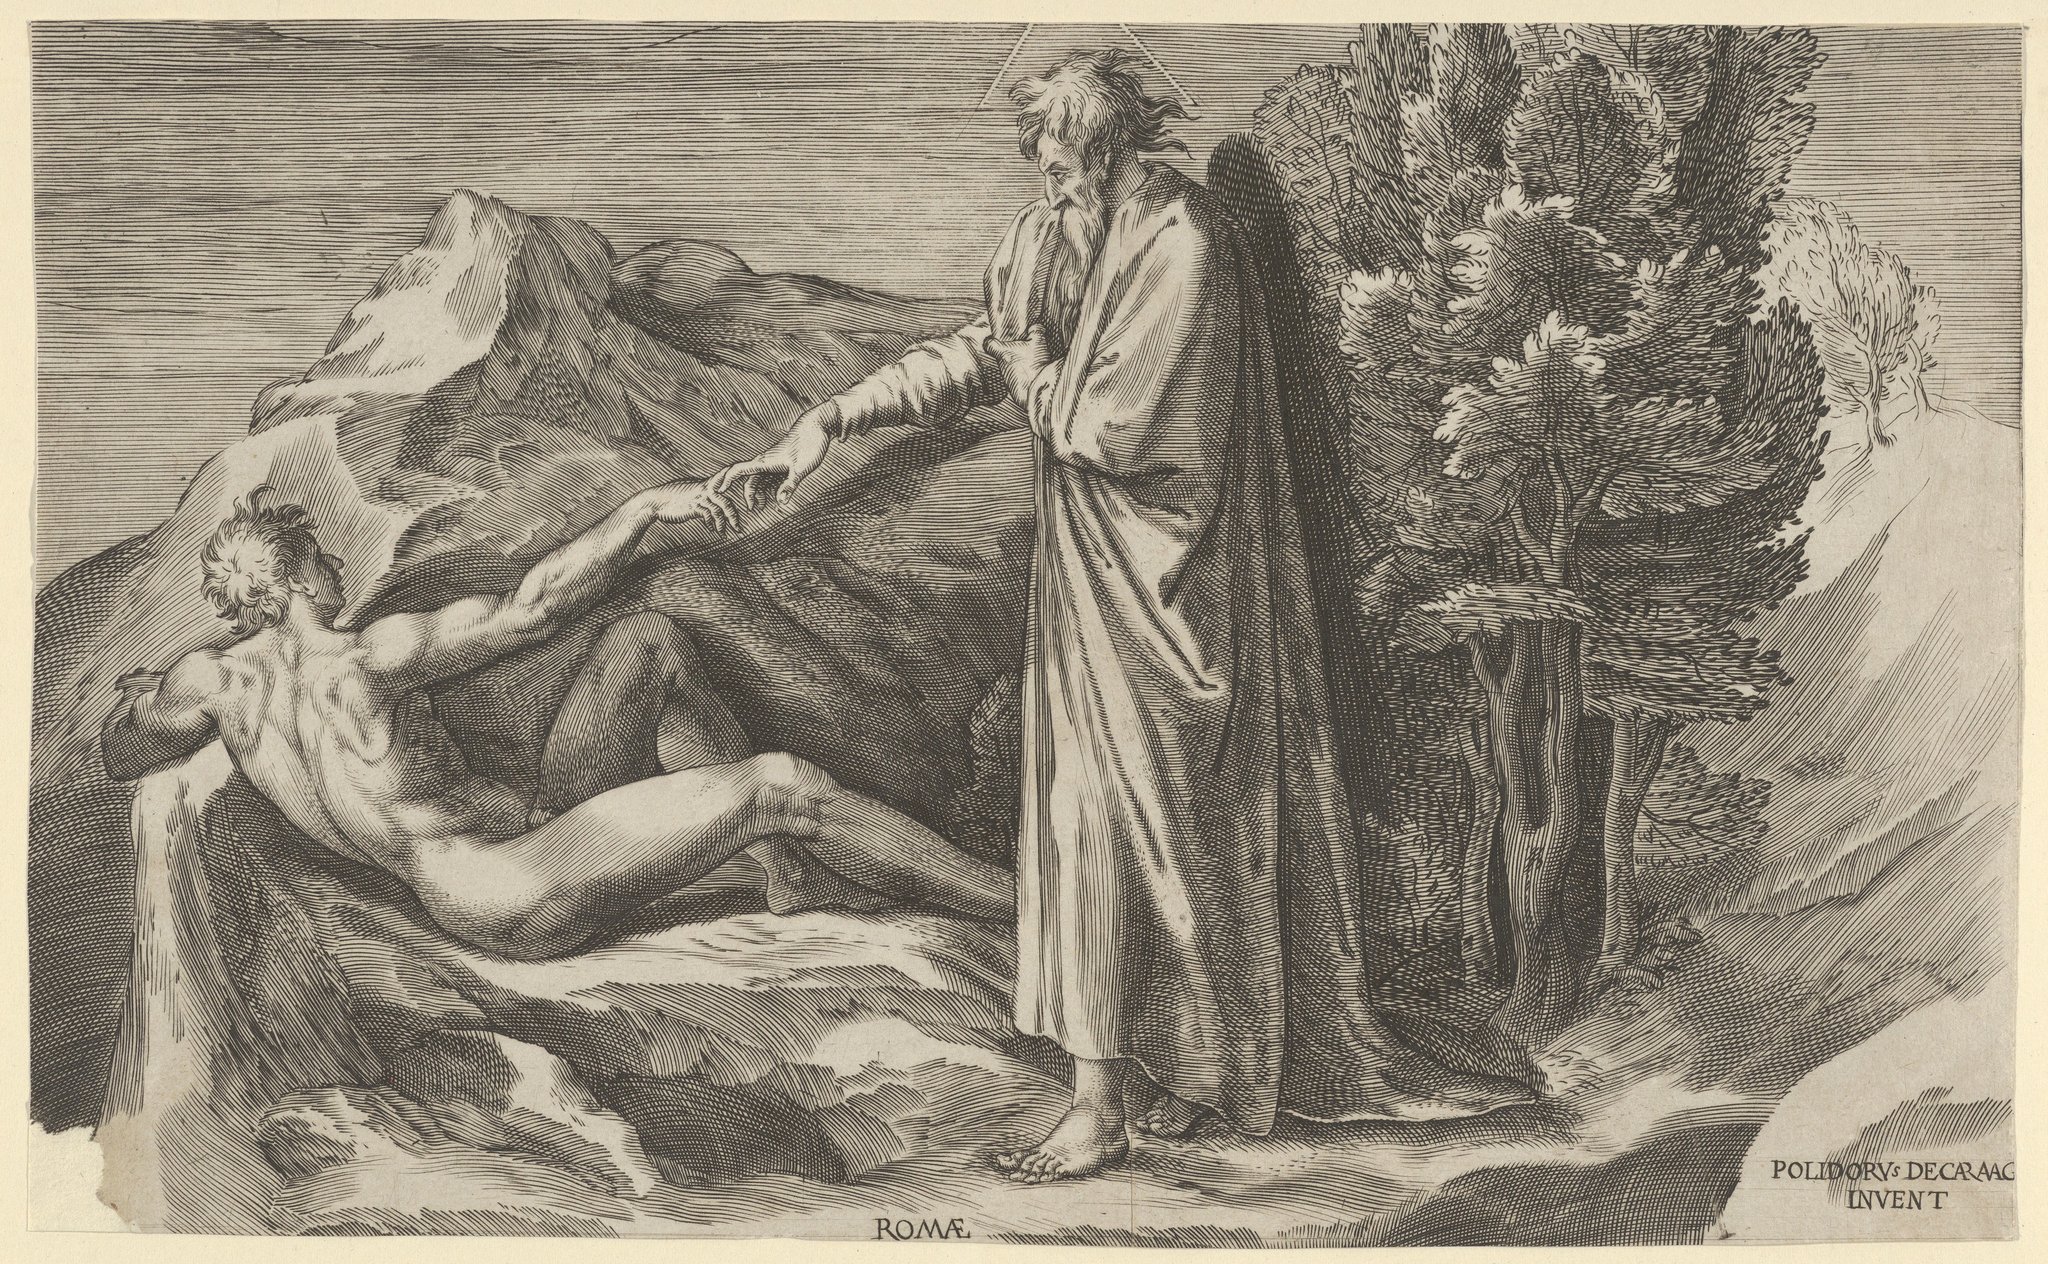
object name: print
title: The Creation of Adam who reclines at left and touching the hand of God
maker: cherubino alberti (zaccaria mattia)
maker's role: artist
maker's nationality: italian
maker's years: 1553-1615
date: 1570-1615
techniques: engraving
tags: male nudes,adam